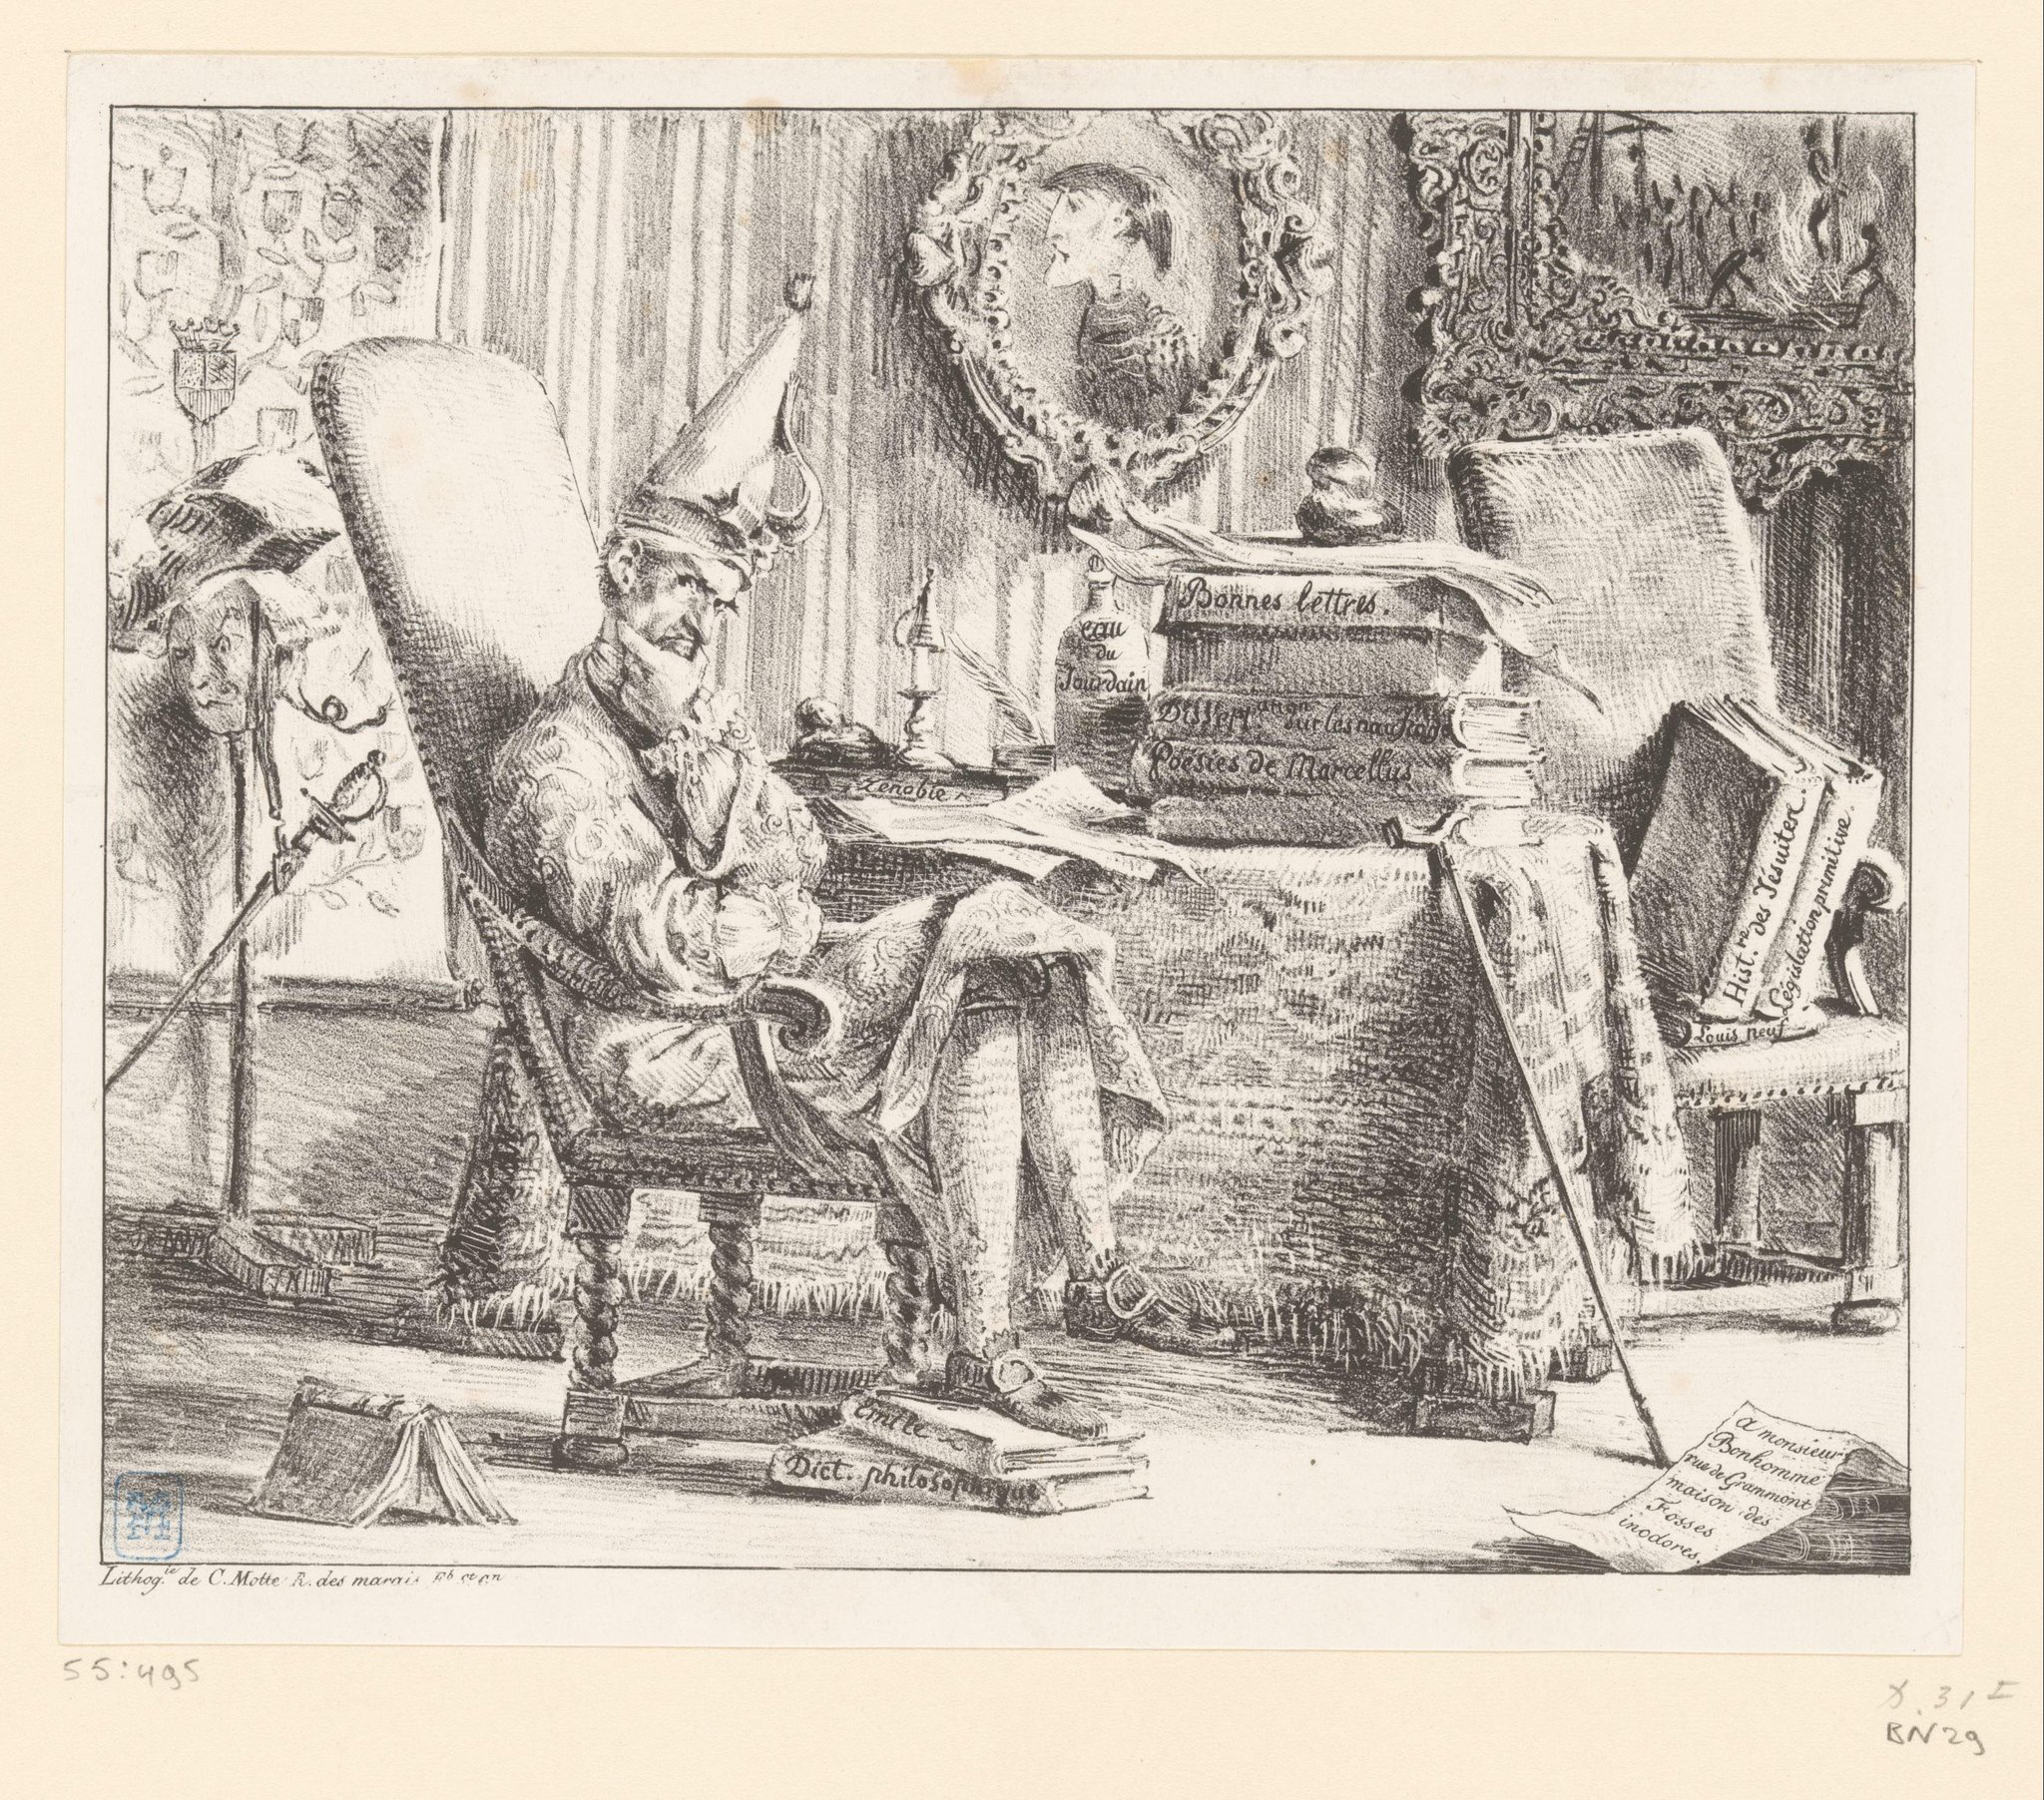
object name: cartoon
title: Karikatuur van een geleerde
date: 1821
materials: paper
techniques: lithograph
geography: paris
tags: scholar in his study, political caricatures and satires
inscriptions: collector's mark: Lugt 1900, collector's mark: Lugt 2760, collector's mark: Lugt 2228a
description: Prent gebruikt in: Le Miroir des spectacles, des lettres, des mœurs et des arts 1 (1821), 3 mei 1821.